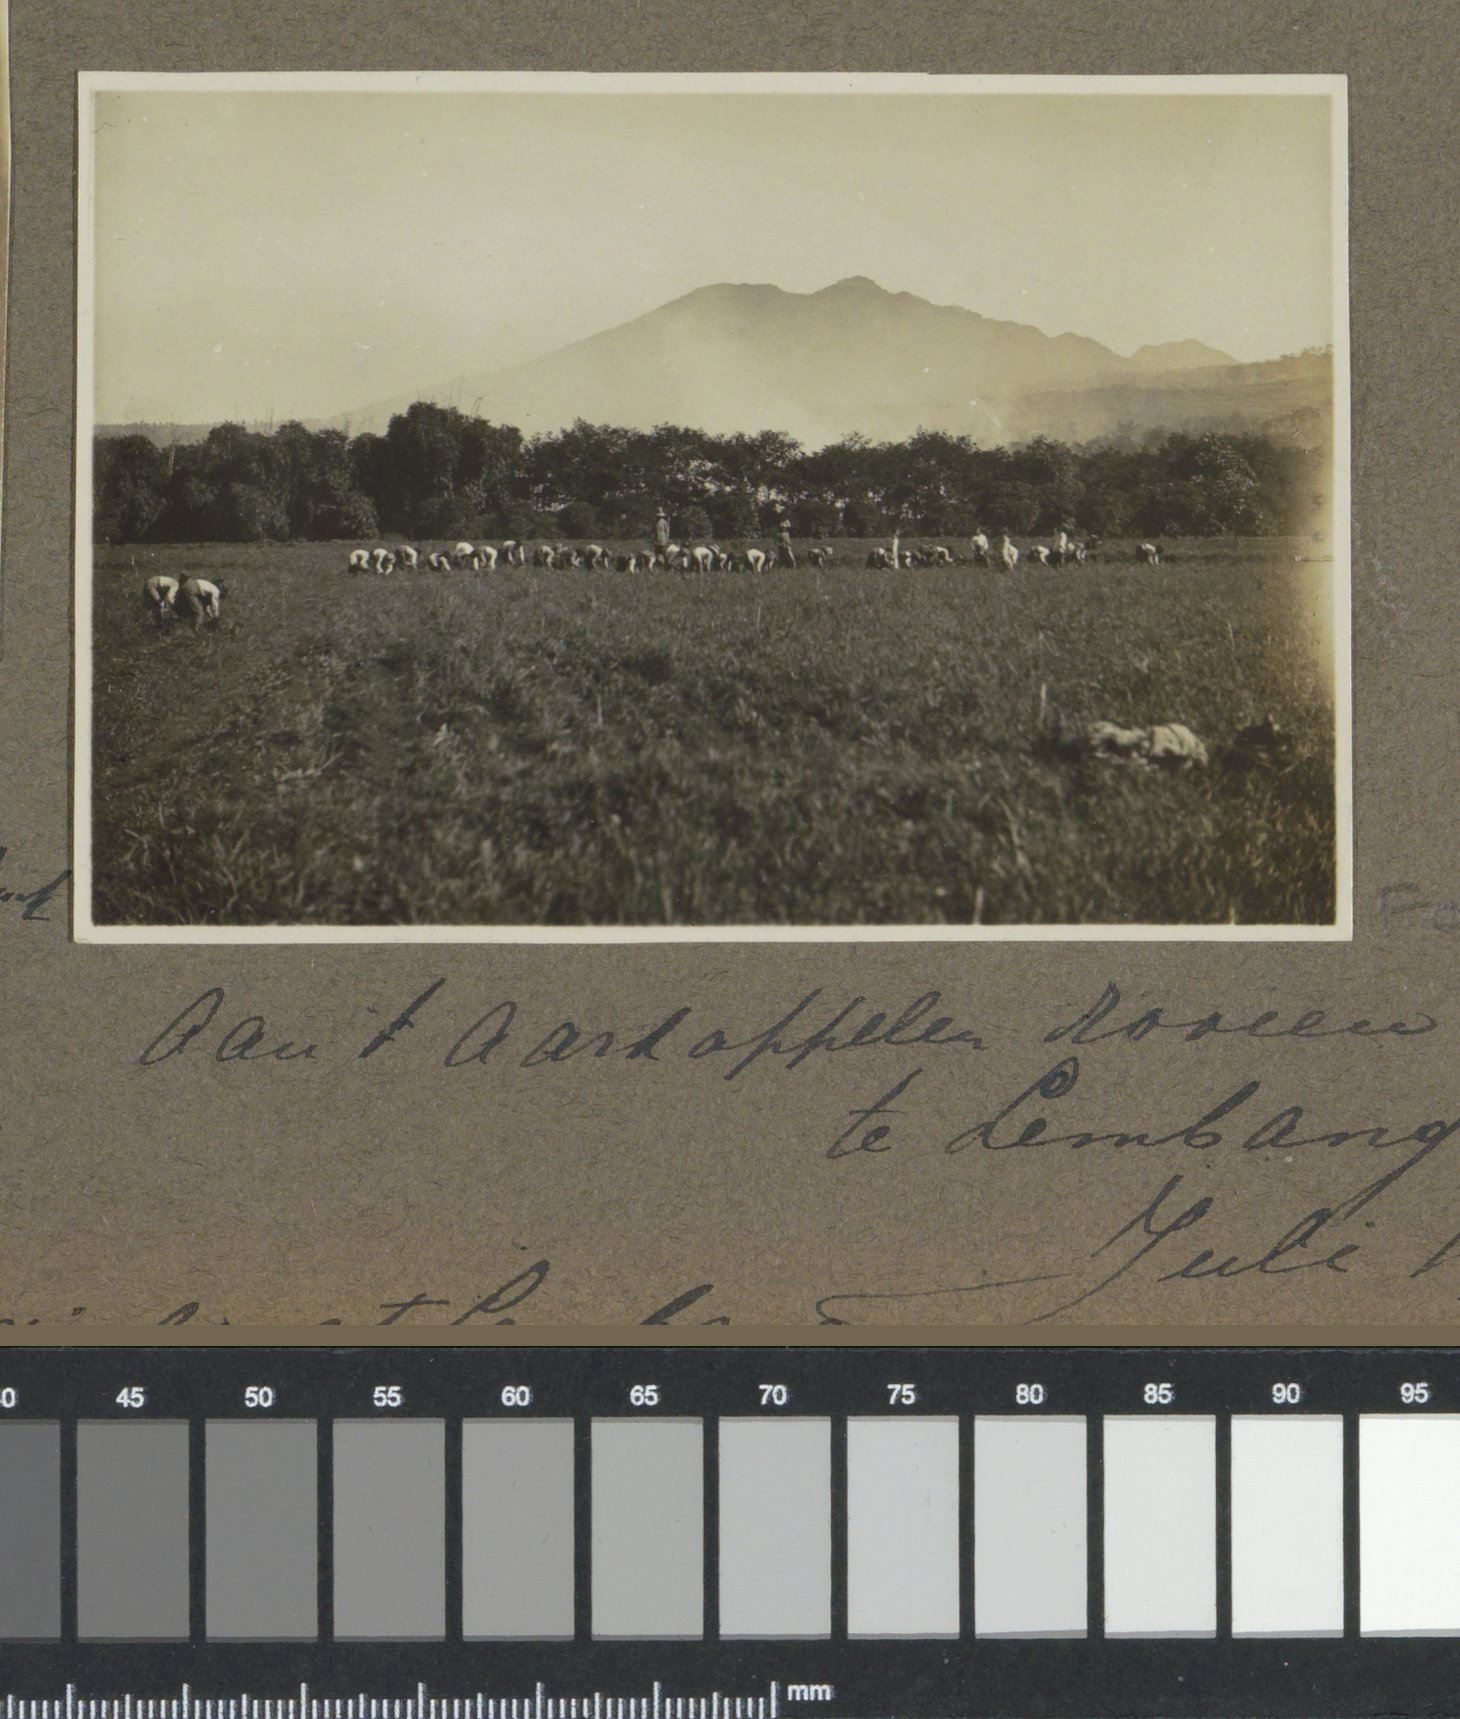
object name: photograph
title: Mensen in een aardappelveld te Lembang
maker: Anonymous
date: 1907-1920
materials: photographic support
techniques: gelatin silver print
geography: lembang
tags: harvest, field filled with a crop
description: Onderdeel van fotoalbum van een onbekende Nederlandse familie met opnames van Suriname, Europa en Nederlands-Indië.